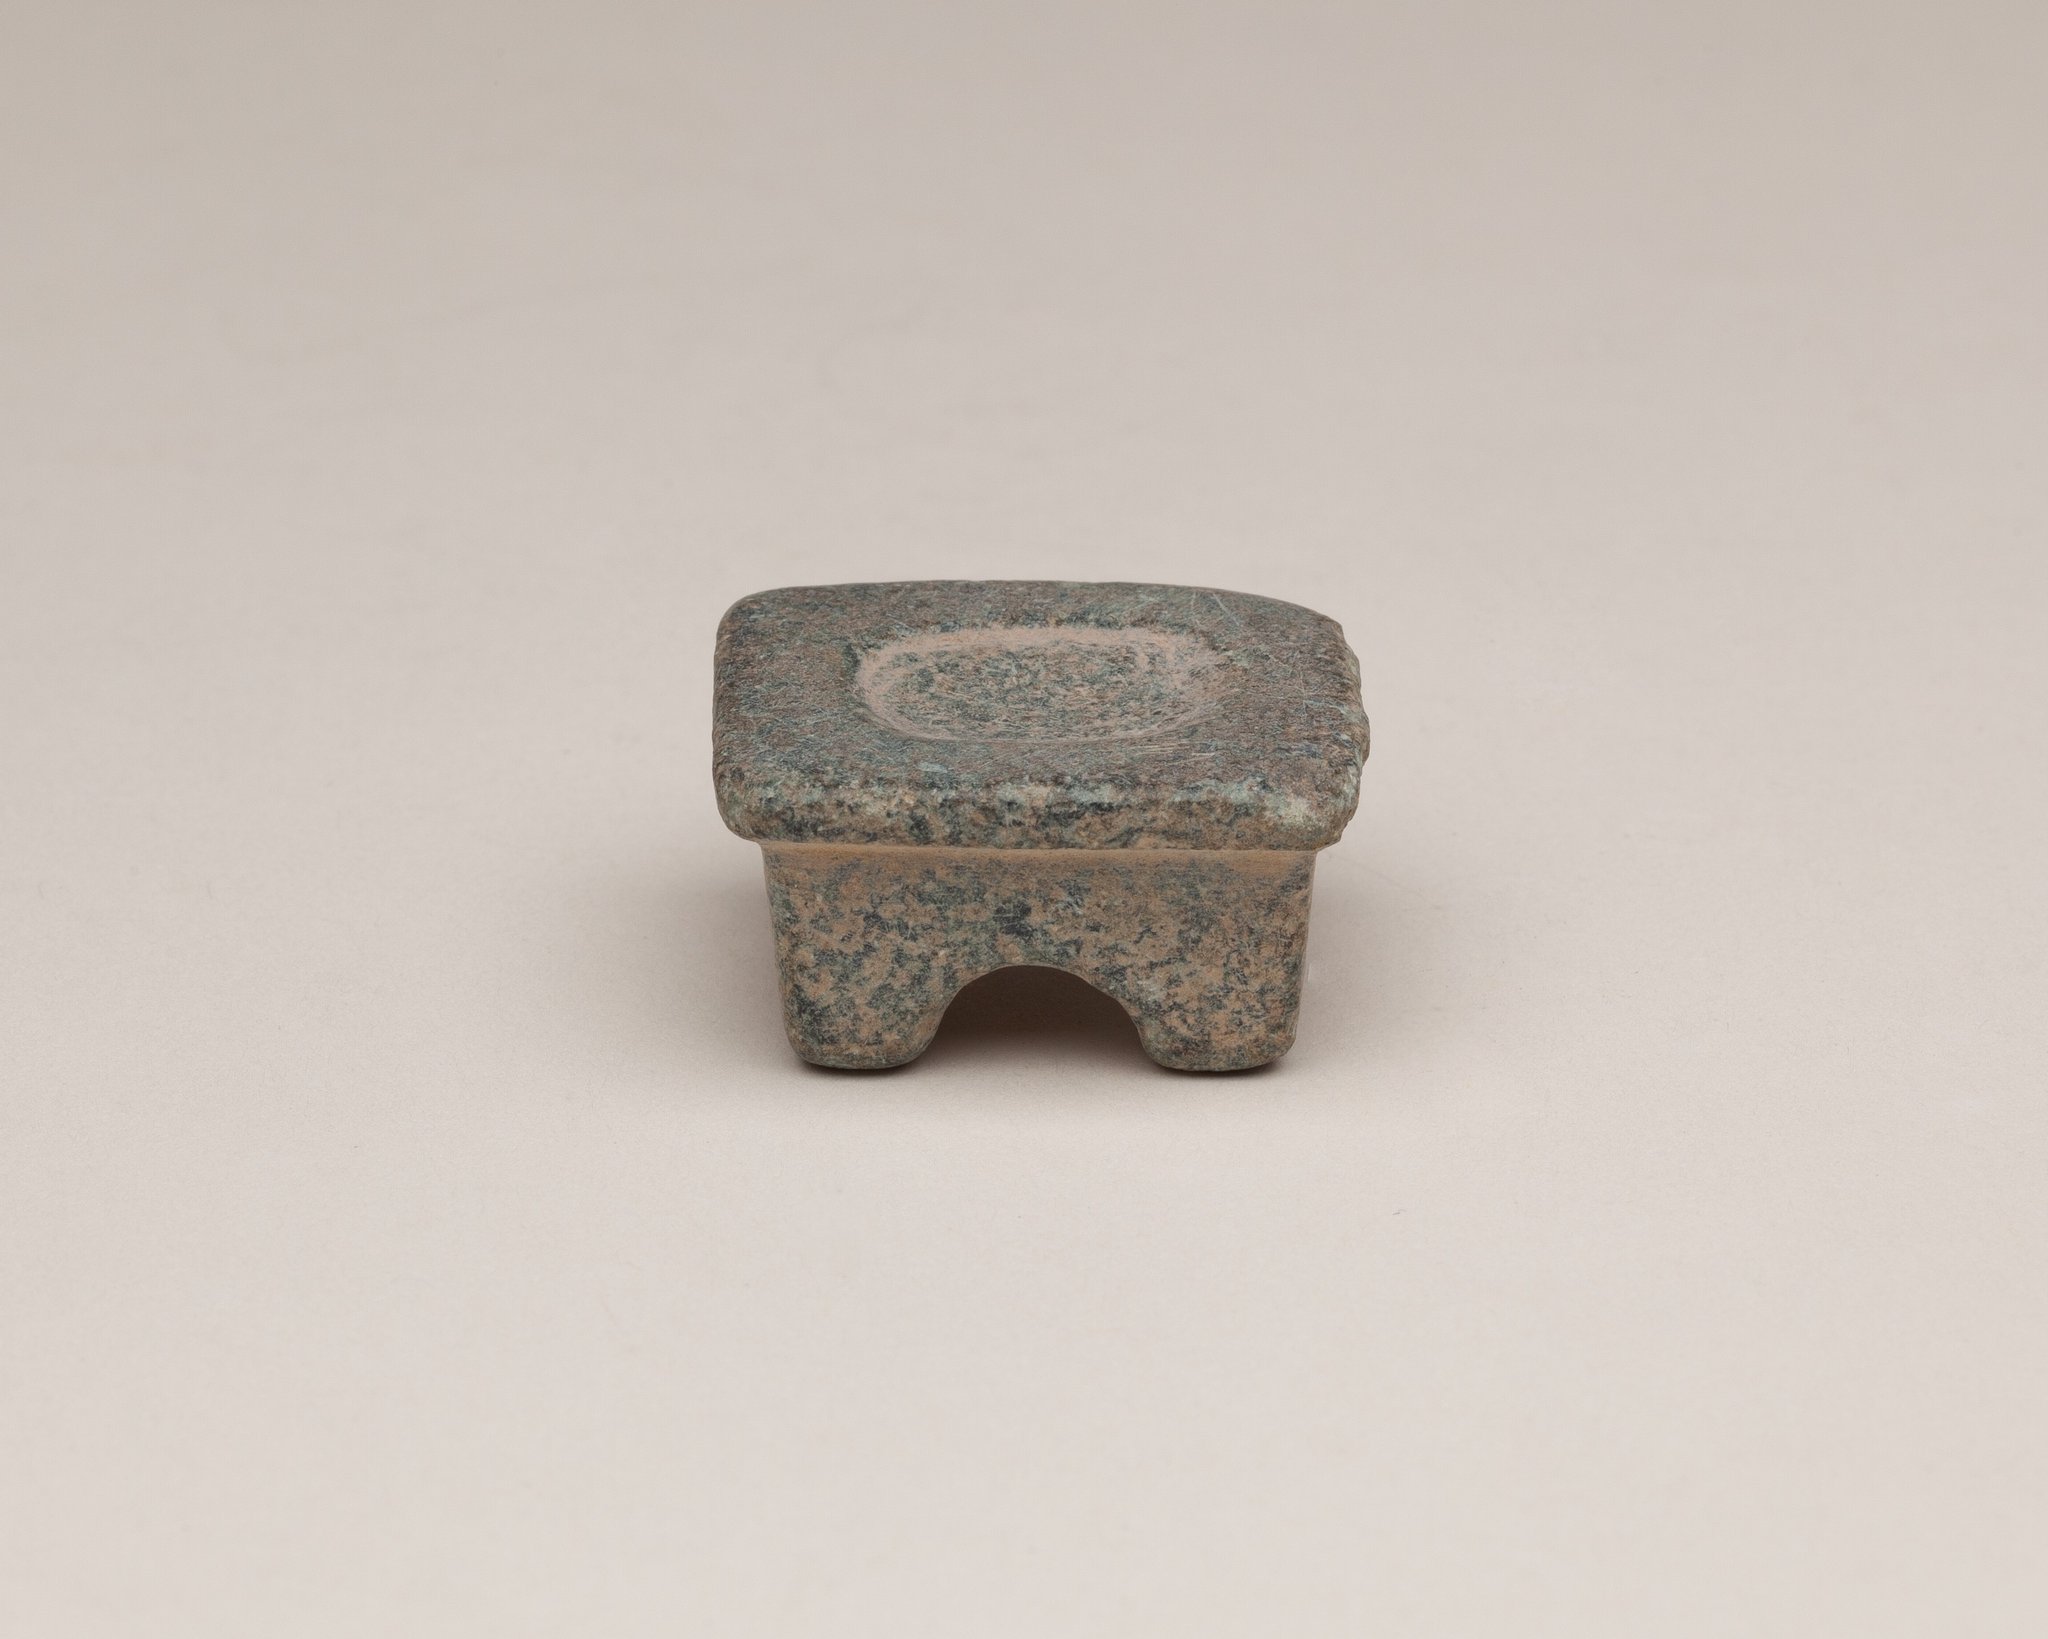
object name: kohl pot stand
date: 1981-1640 BCE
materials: stone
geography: egypt